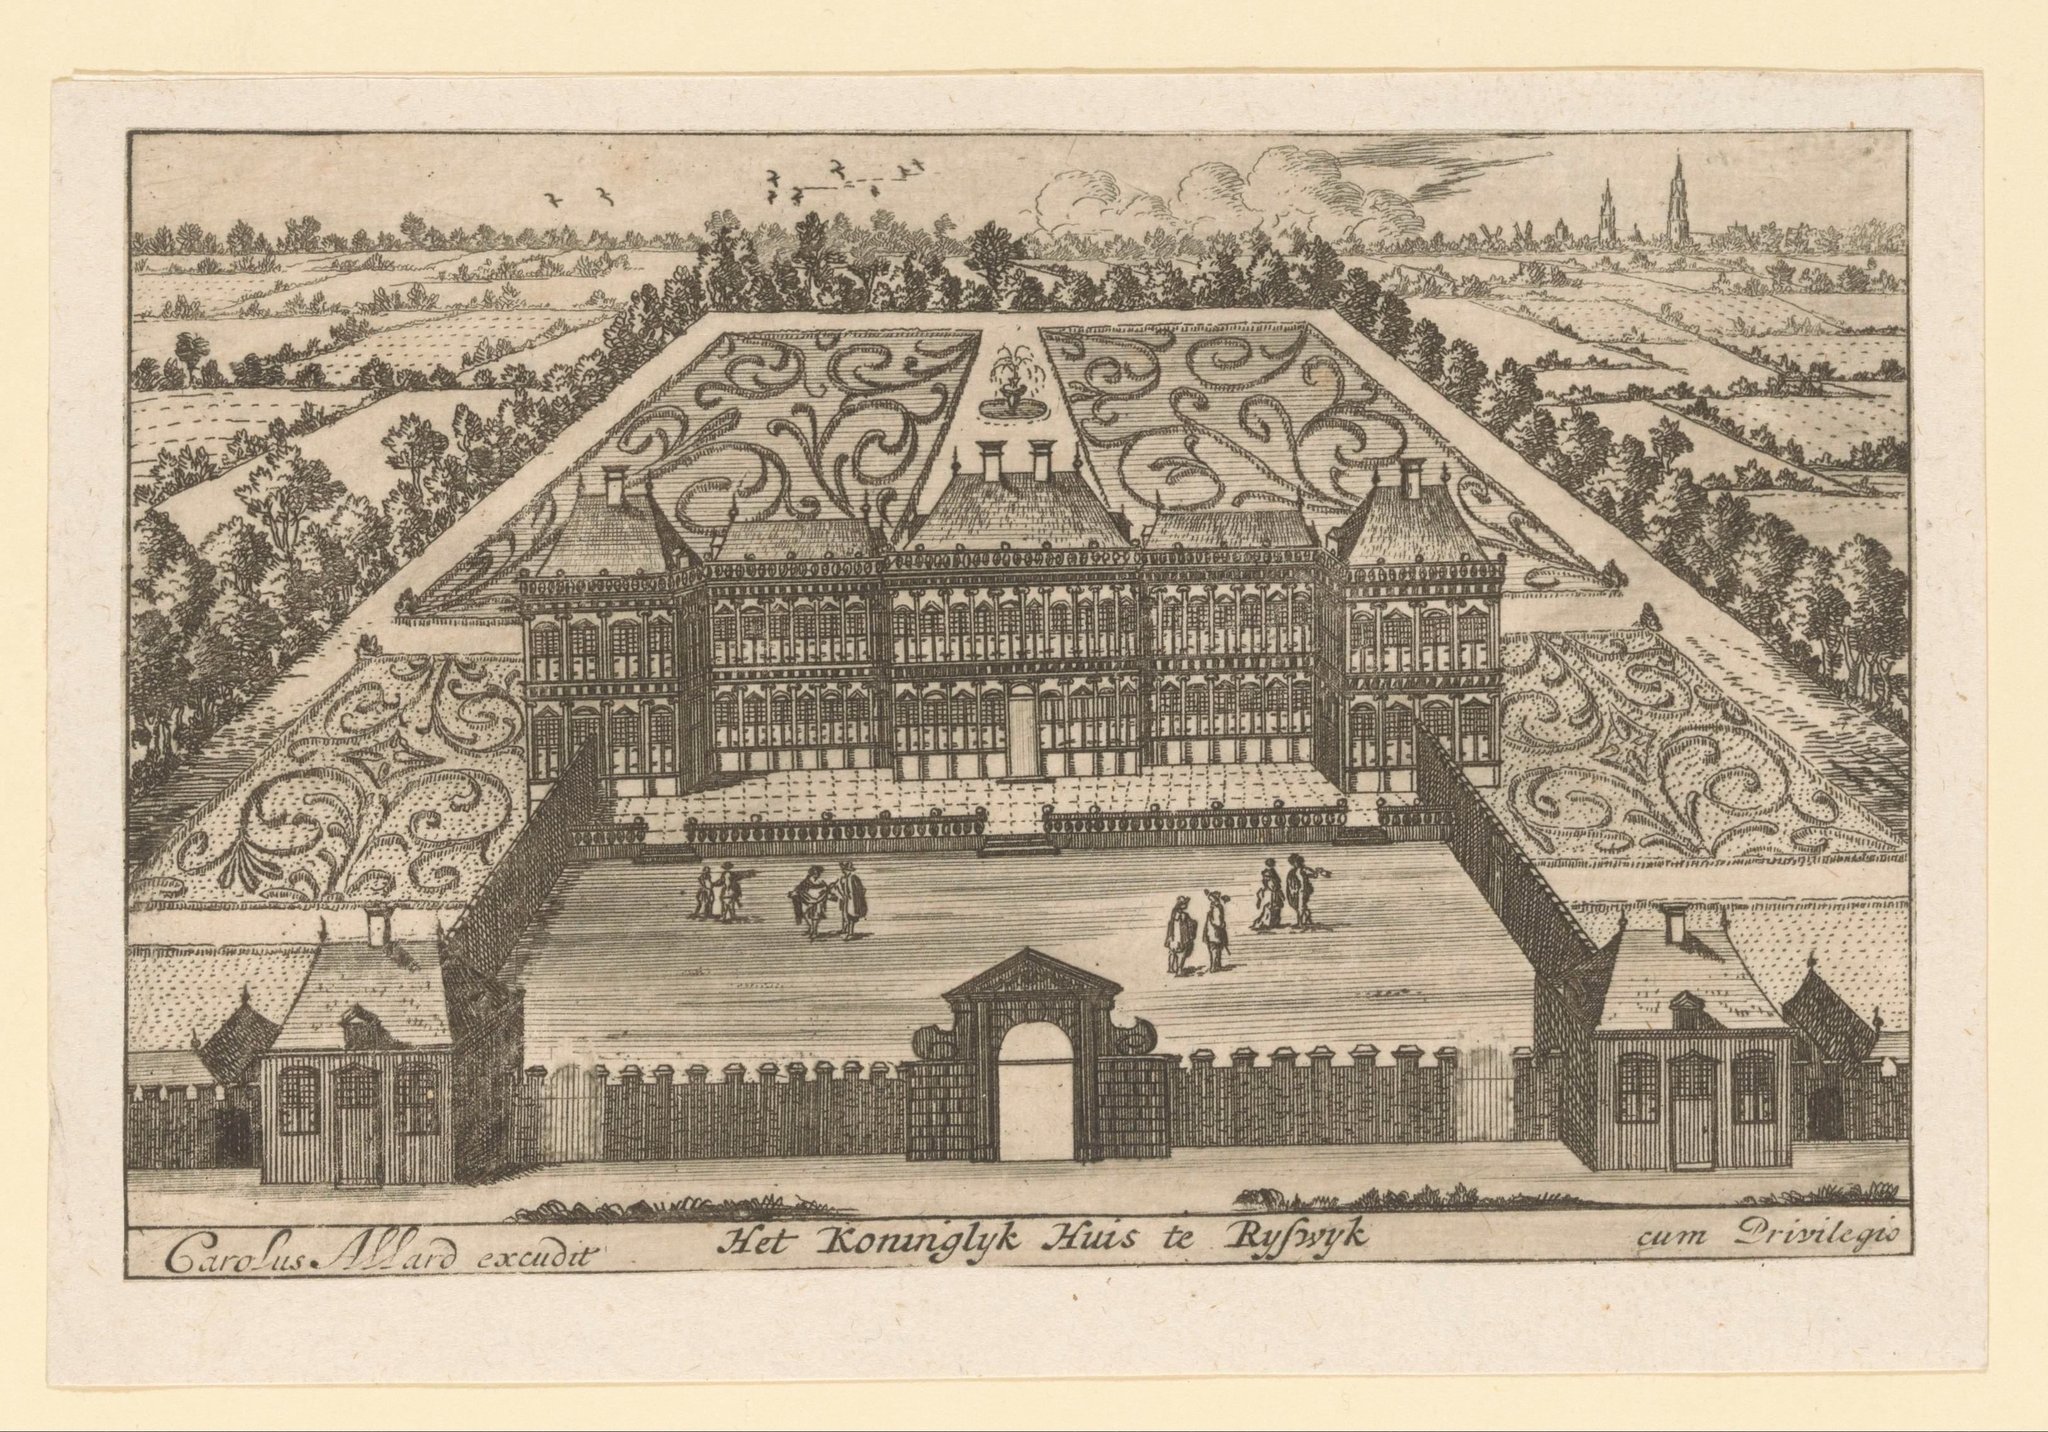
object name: print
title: Het koninglyk huis te Ryswyk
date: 1663-1670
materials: paper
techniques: engraving, etching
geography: amsterdam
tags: garden, palace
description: Eerdere staat van prent ook gebruikt in: Does, Jacob van der. 's Graven-Hage, met de voornaemste plaetsen en vermaecklijckheden. Den Haag: Hermanus Gael, 1668, tussen p. 56 en 57. Of in: Does, Jacob van der. 's Graven-Hage, met de voornaemste plaetsen en vermaecklijckheden. Den Haag: Johannes Tongerloo, 1668, tussen p. 56 en 57. Of in: Does, Jacob van der. 's Graven-Hage, met de voornaemste plaetsen en vermaeklykheden. Den Haag: Abraham Troyel, 1700. Zie ook RP-P-1887-A-12074.